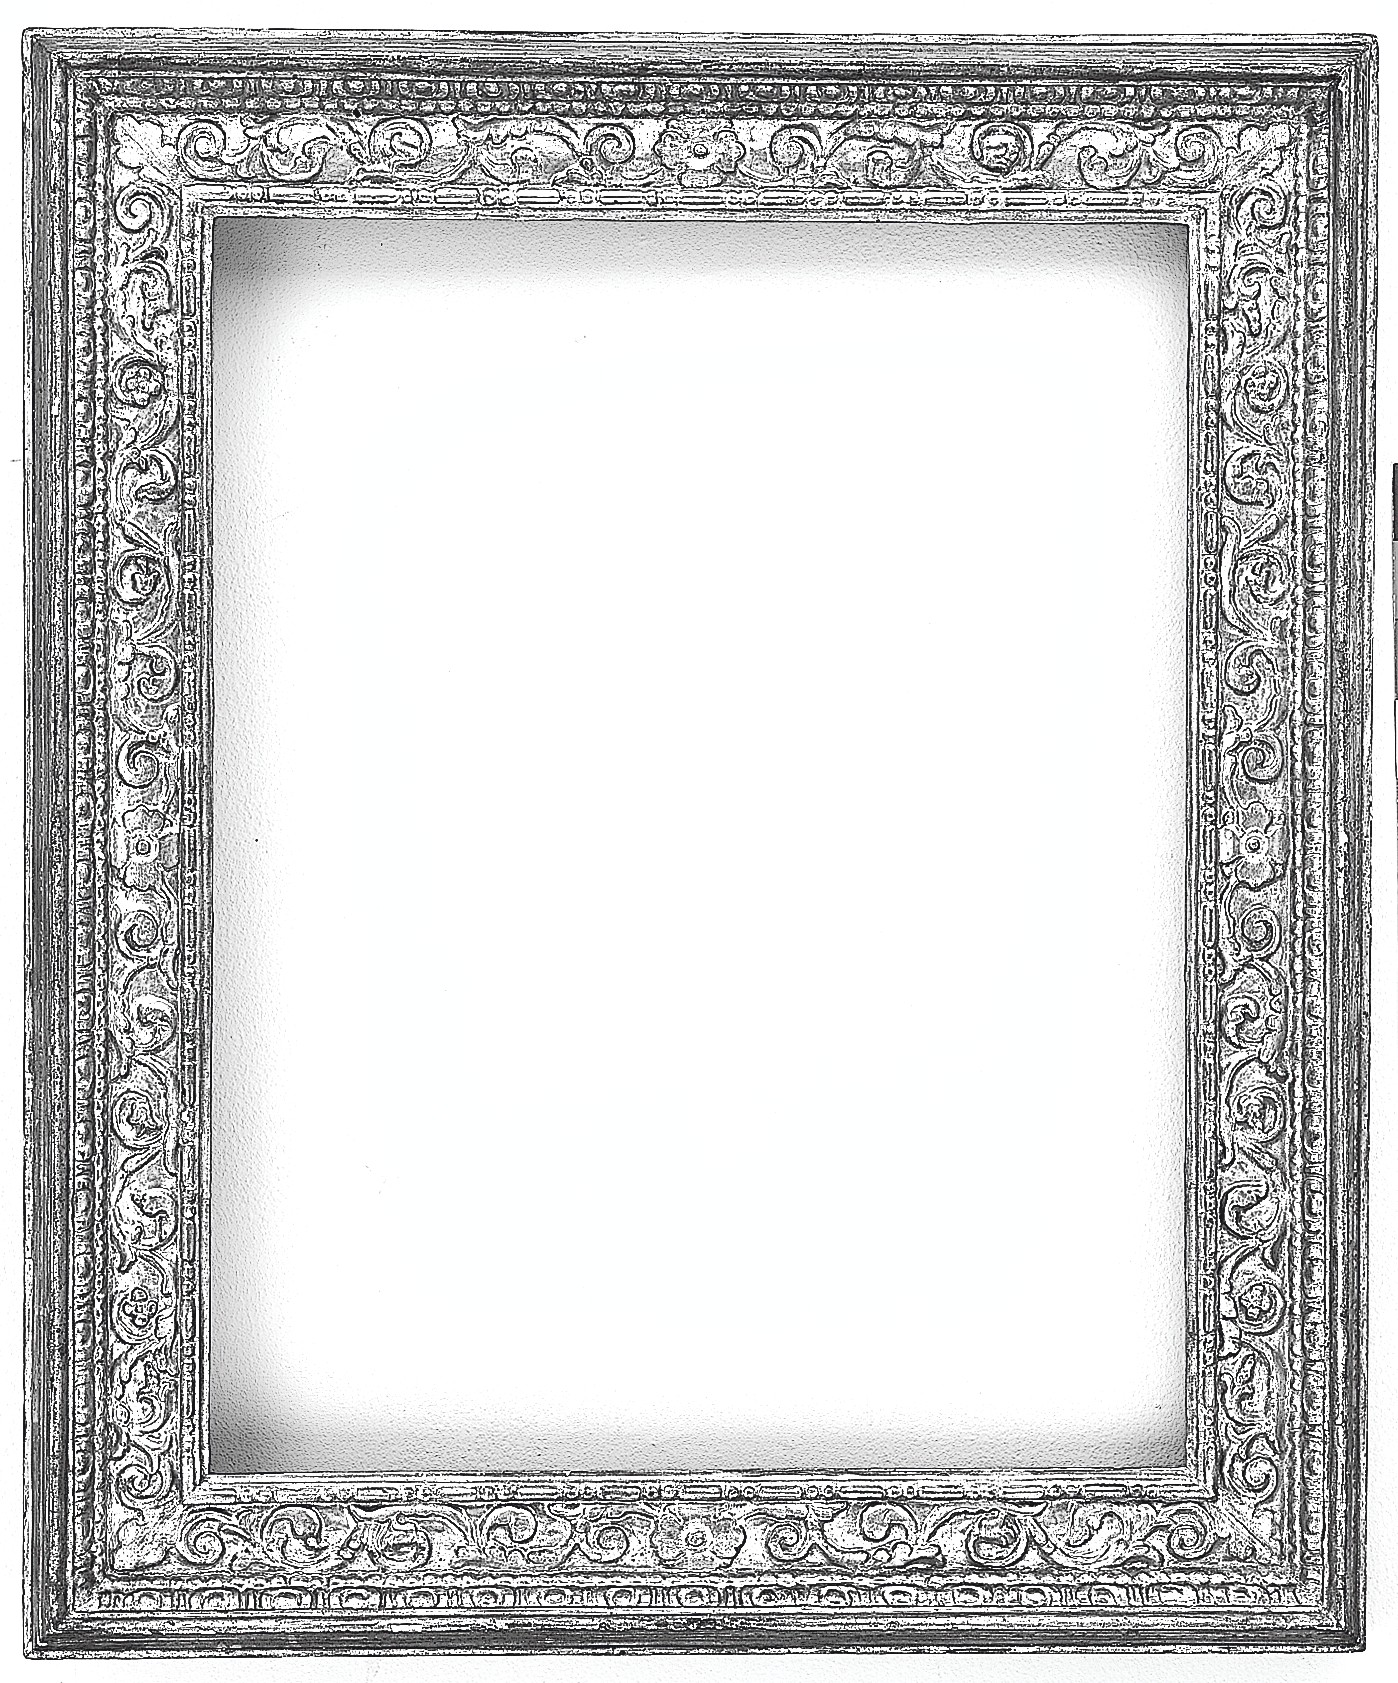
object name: frame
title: Cassetta frame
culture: italian, veneto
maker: italian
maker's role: artist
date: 1501-1600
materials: wood